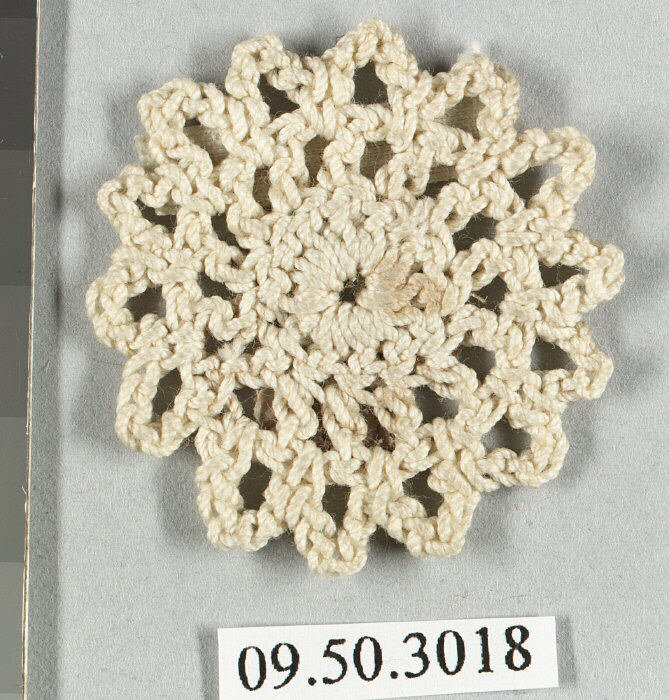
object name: sample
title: Crochet work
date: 1801-1900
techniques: crochet